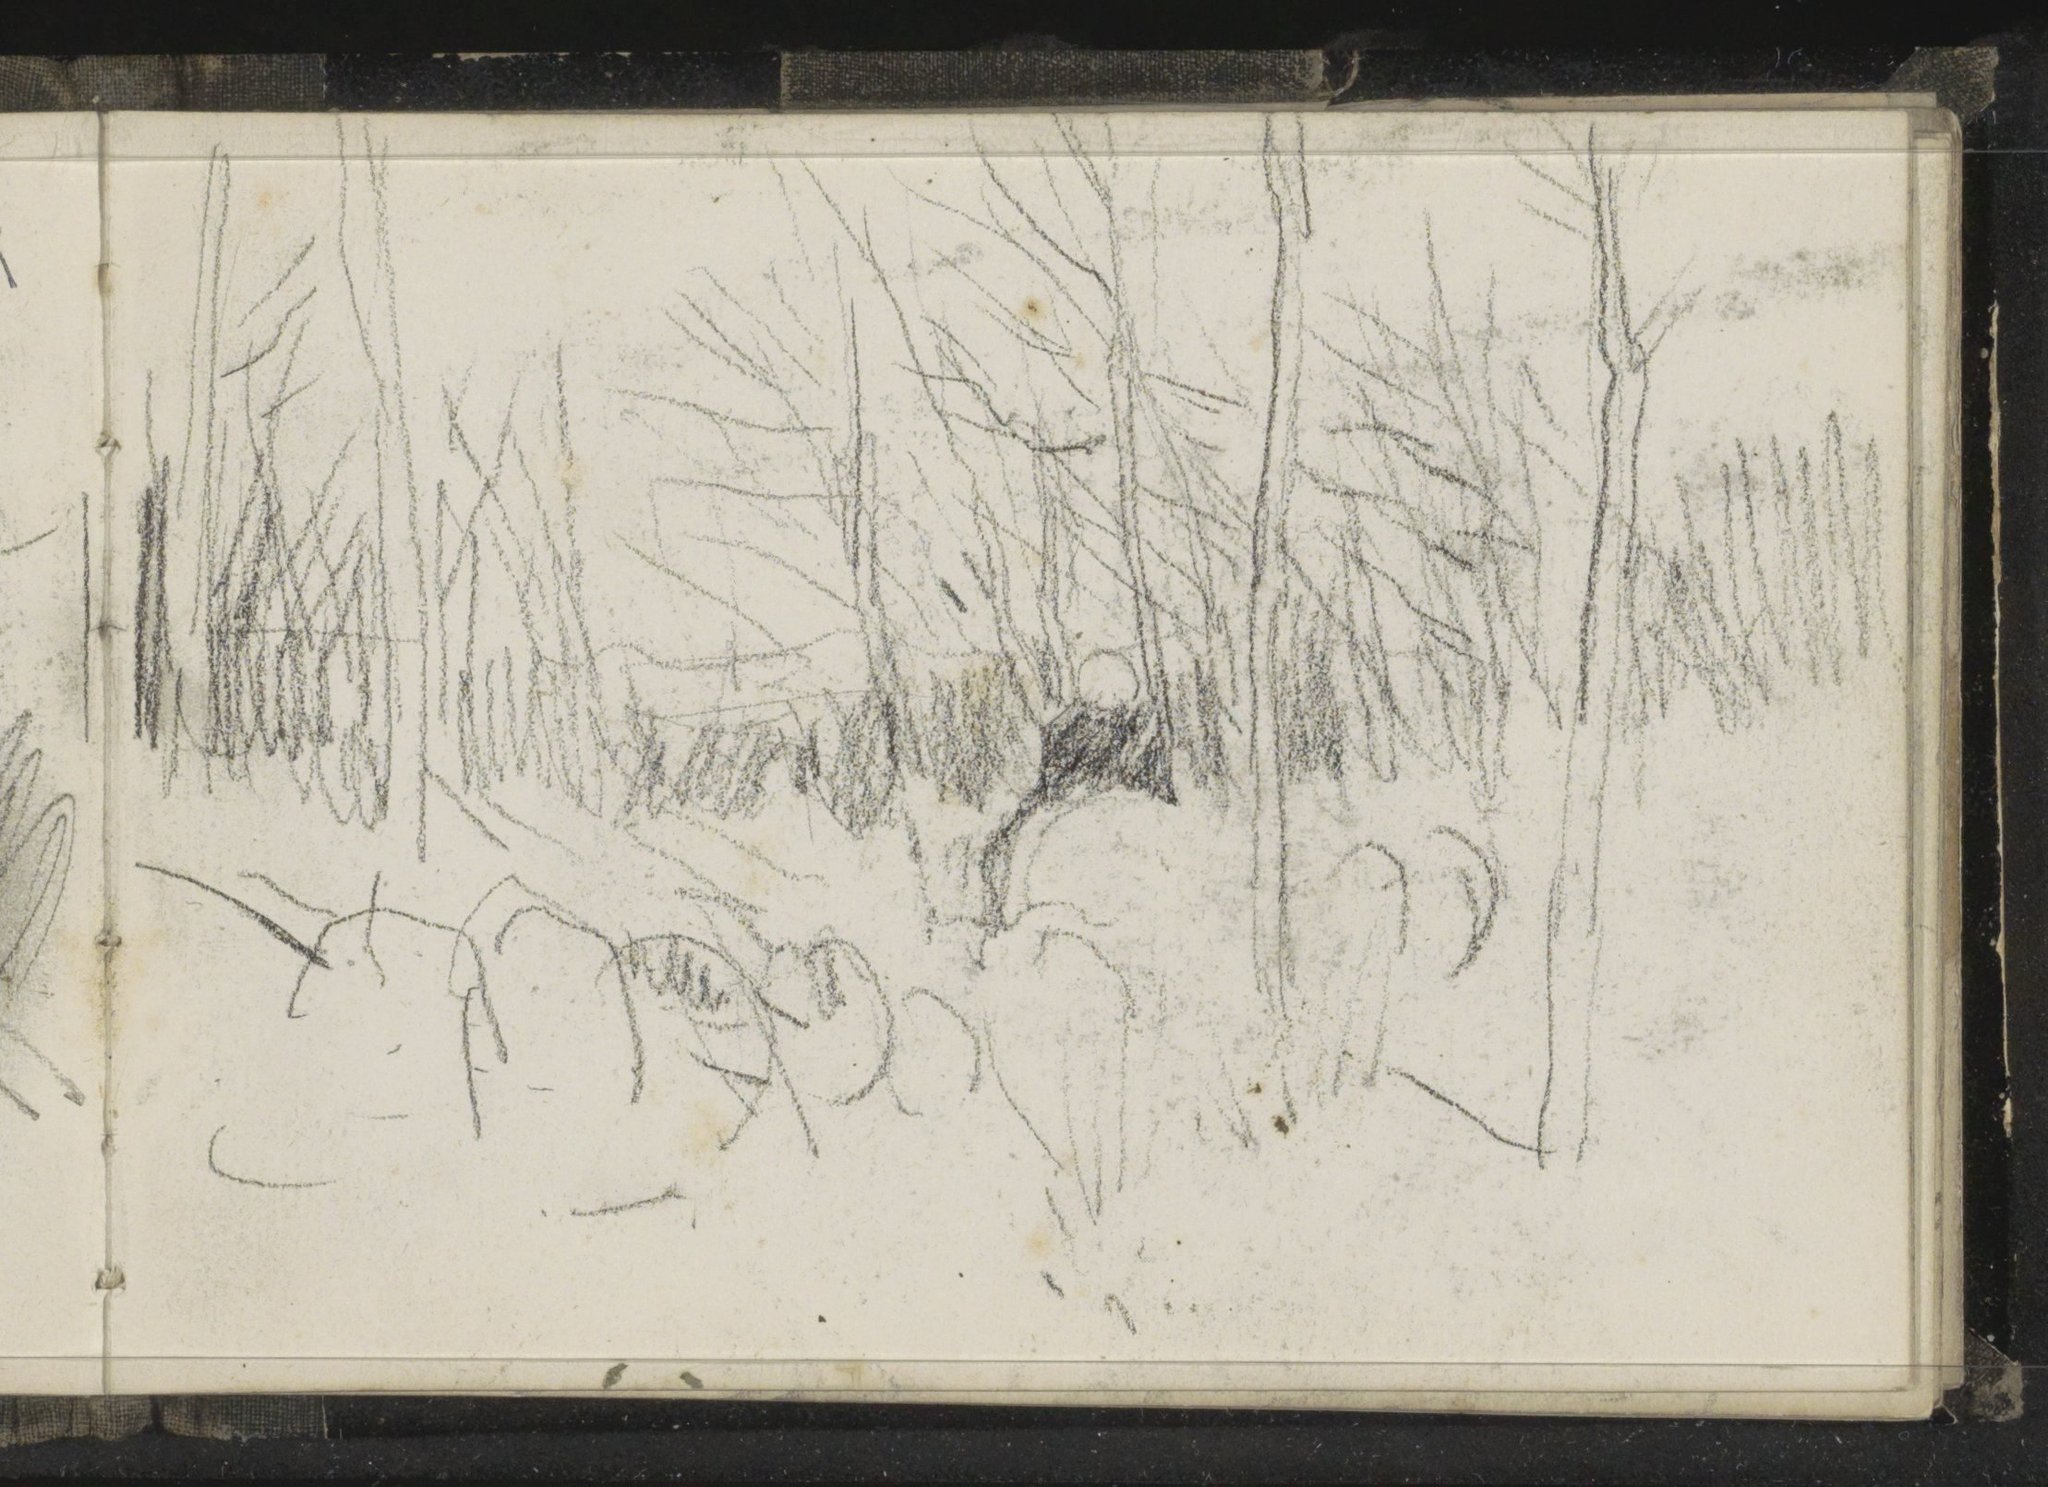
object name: sketchbook leaf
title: Bomen en struiken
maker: anton mauve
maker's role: draughtsman, painter, print maker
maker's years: 1838-1888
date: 1848-1888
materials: chalk, paper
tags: landscapes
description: Op de voorgrond mogelijk een figuur en schapen. Blad 11 recto uit een schetsboek met 33 bladen.